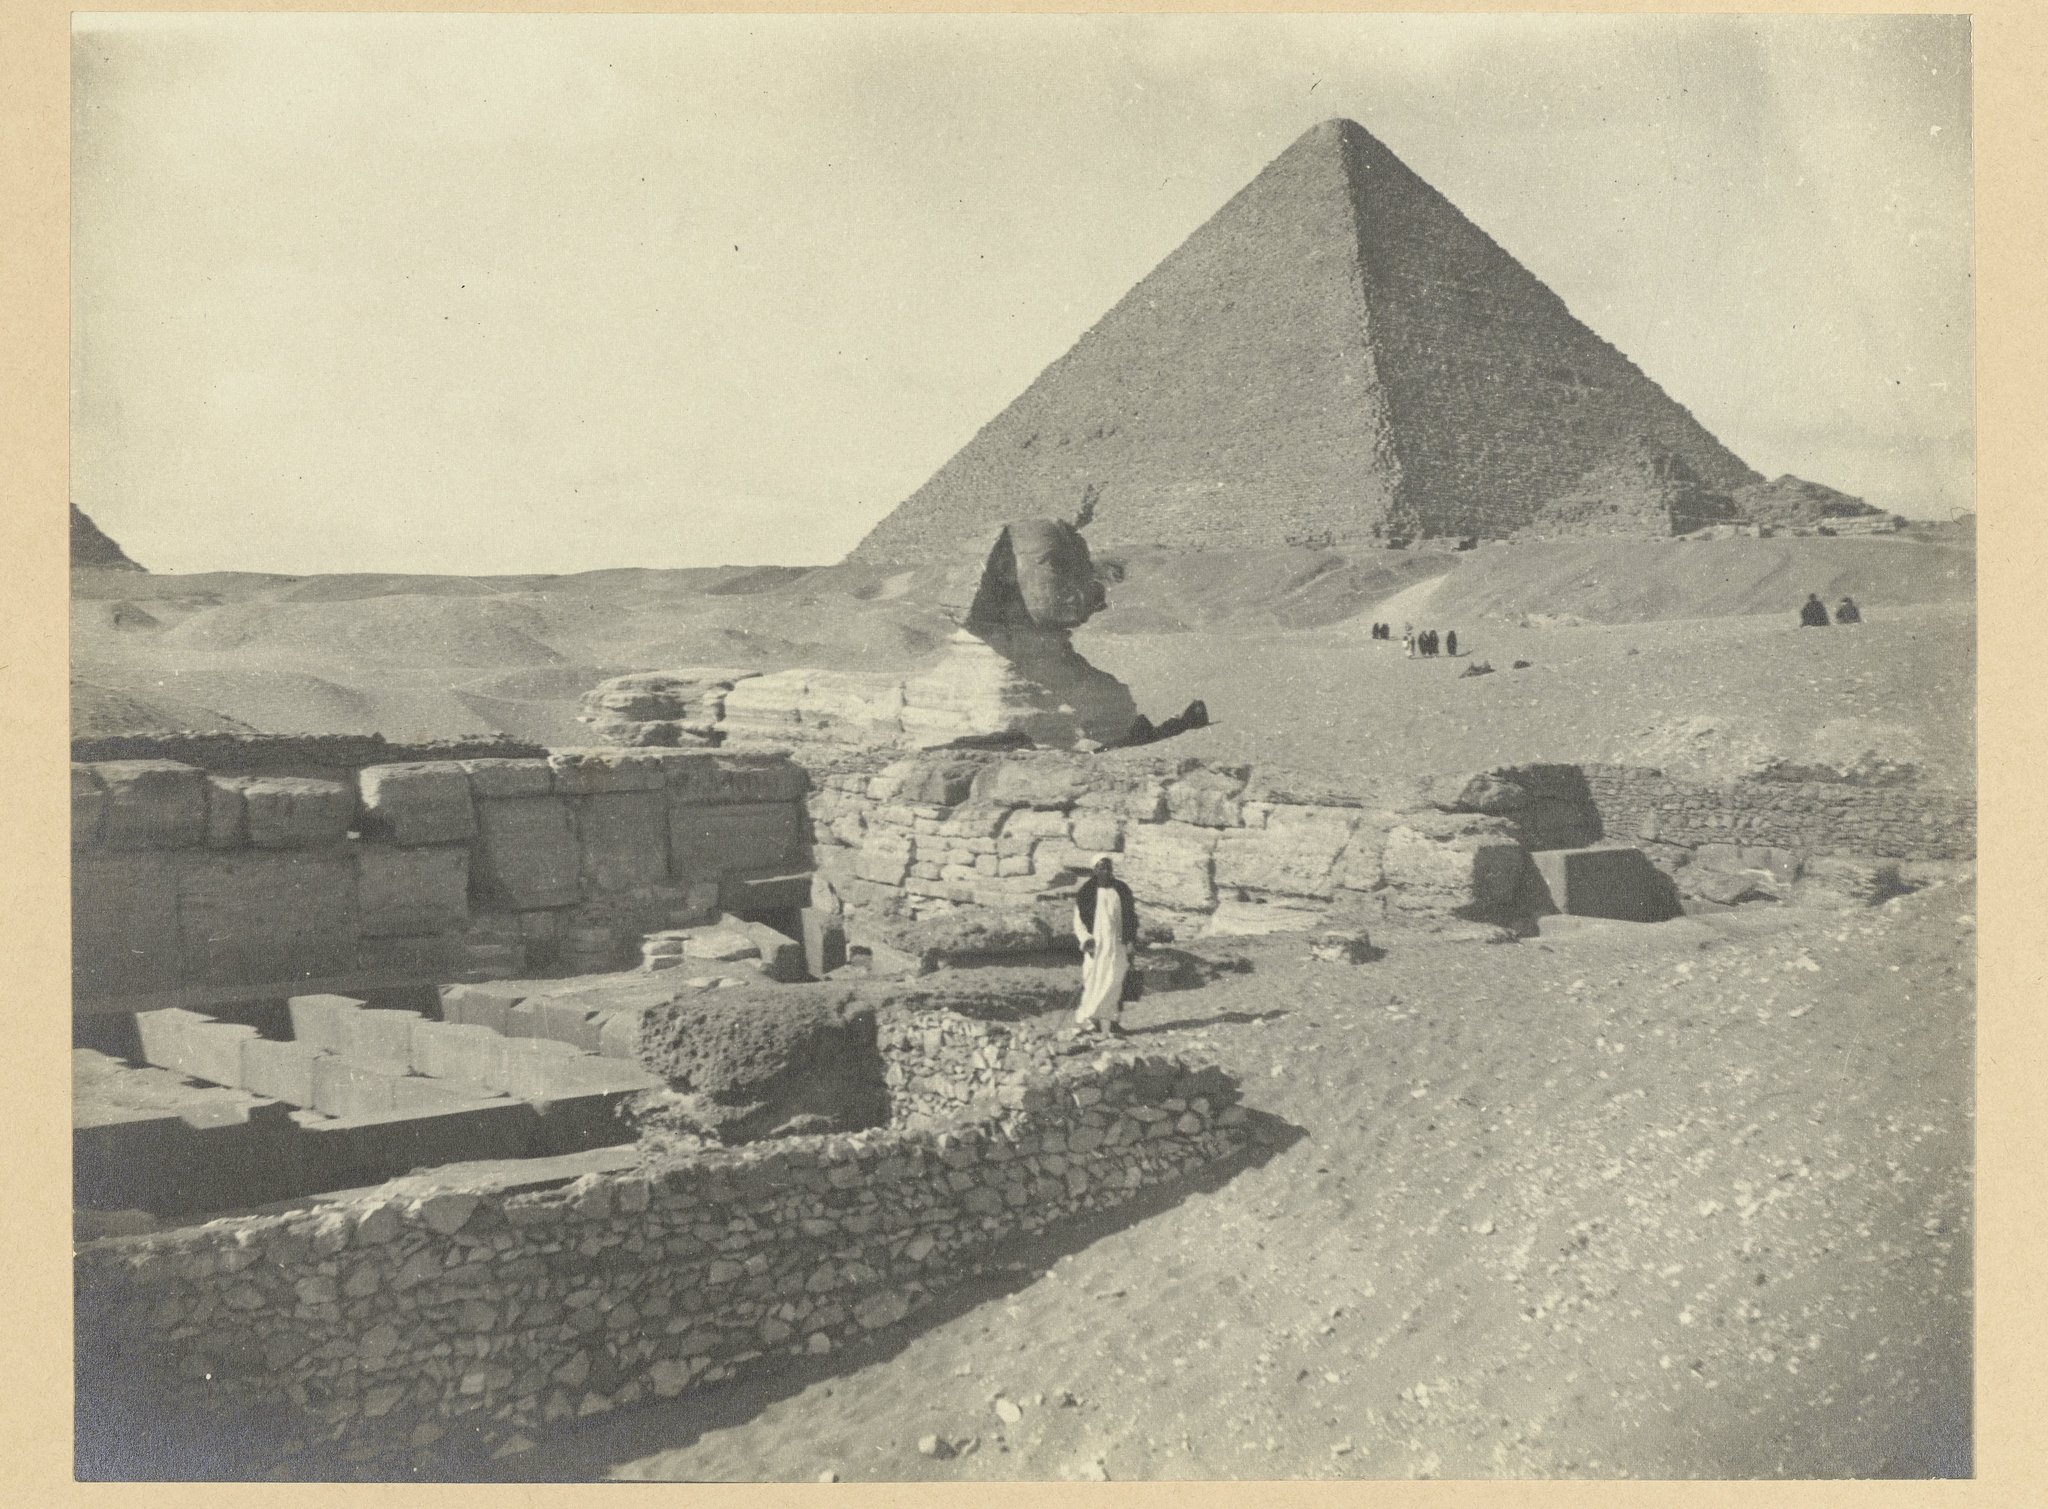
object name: photograph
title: Pyramide, Sfinx en graven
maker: mr. l. de bruyn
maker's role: fotograaf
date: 1900-1910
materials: paper, cardboard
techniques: gelatin silver print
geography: gizeh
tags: sphinx (lion/woman); 'sfinge' (ripa), pyramid (historical grave form)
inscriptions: title: ‘Pyramide, Sfinx & Graven/ door LDB.’, stamp: ‘Gemeentelijke bibliotheek/ Rotterdam’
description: Onderdeel van een groep door fotograaf Richard Polak op reis verzamelde foto’s. Deze foto is rond 1910 gemaakt door zijn reisgenoot mr. L. de Bruyn. Foto’s die hij op eerdere reizen verzamelde zijn tentoongesteld bij de Rotterdamsche Kunstkring (1895), Arti en Amicitiae te Amsterdam (1897-1898?) en Societeit 't Collegie te Kampen (datum vooralsnog onbekend).